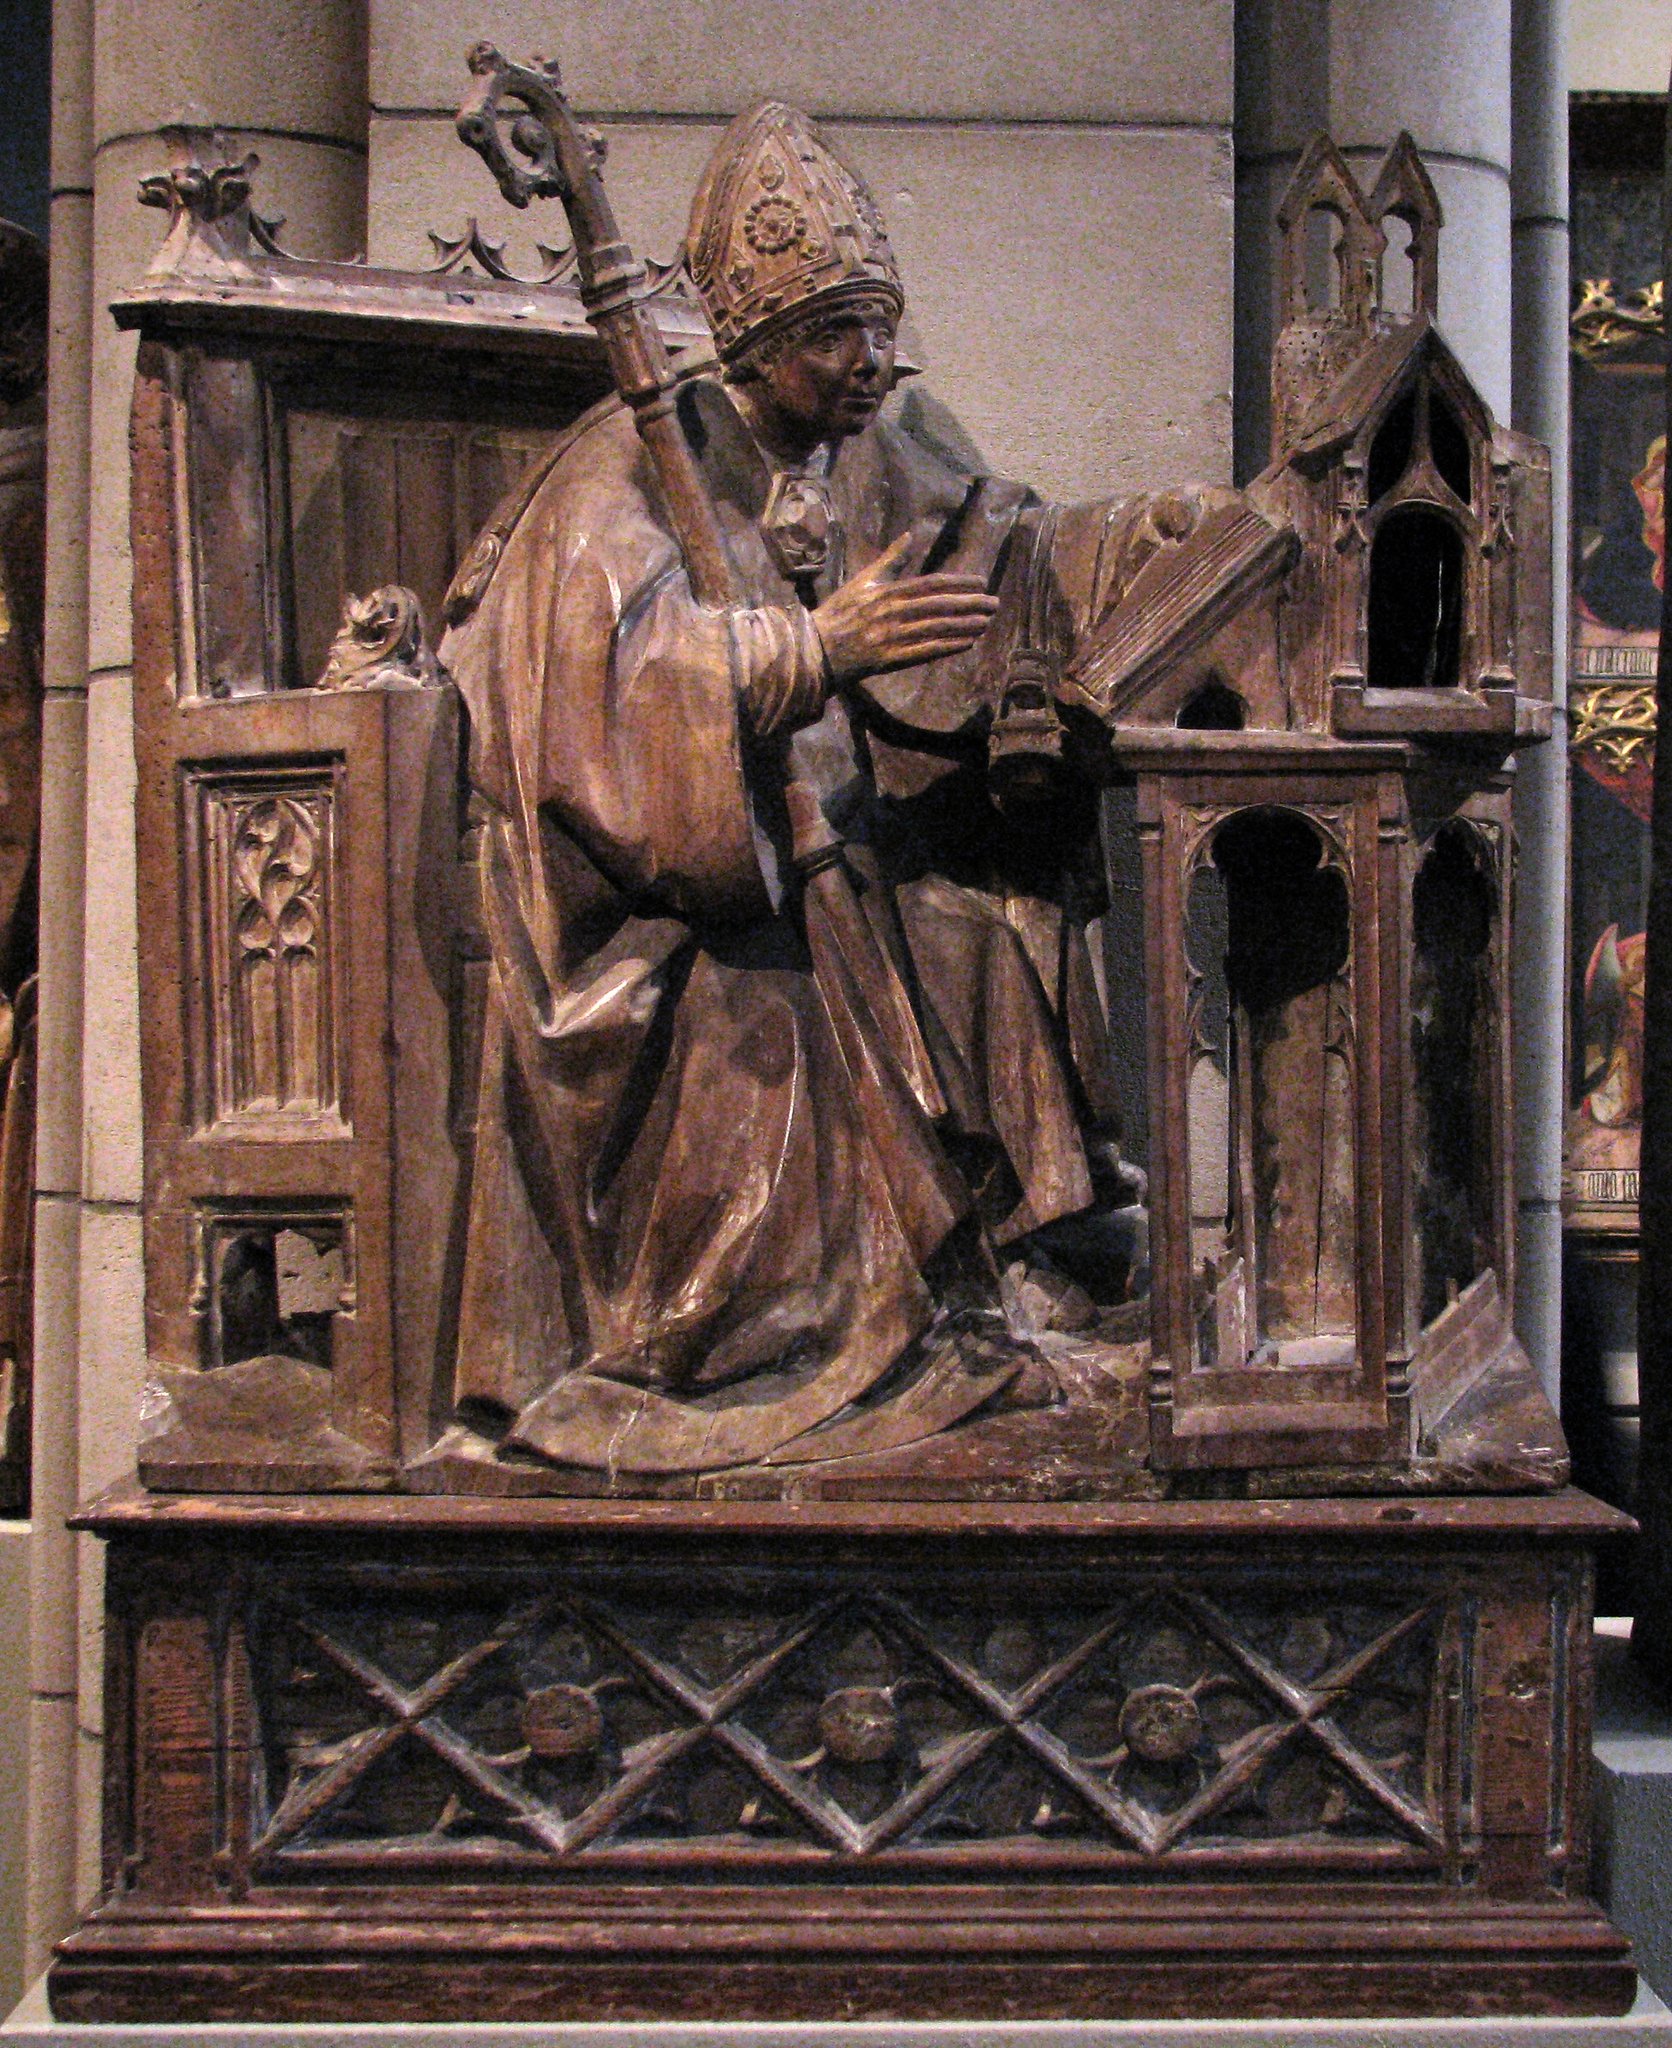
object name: relief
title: Saint Ambrose in His Study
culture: spanish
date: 1500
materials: paint, wood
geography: spain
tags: men,reading